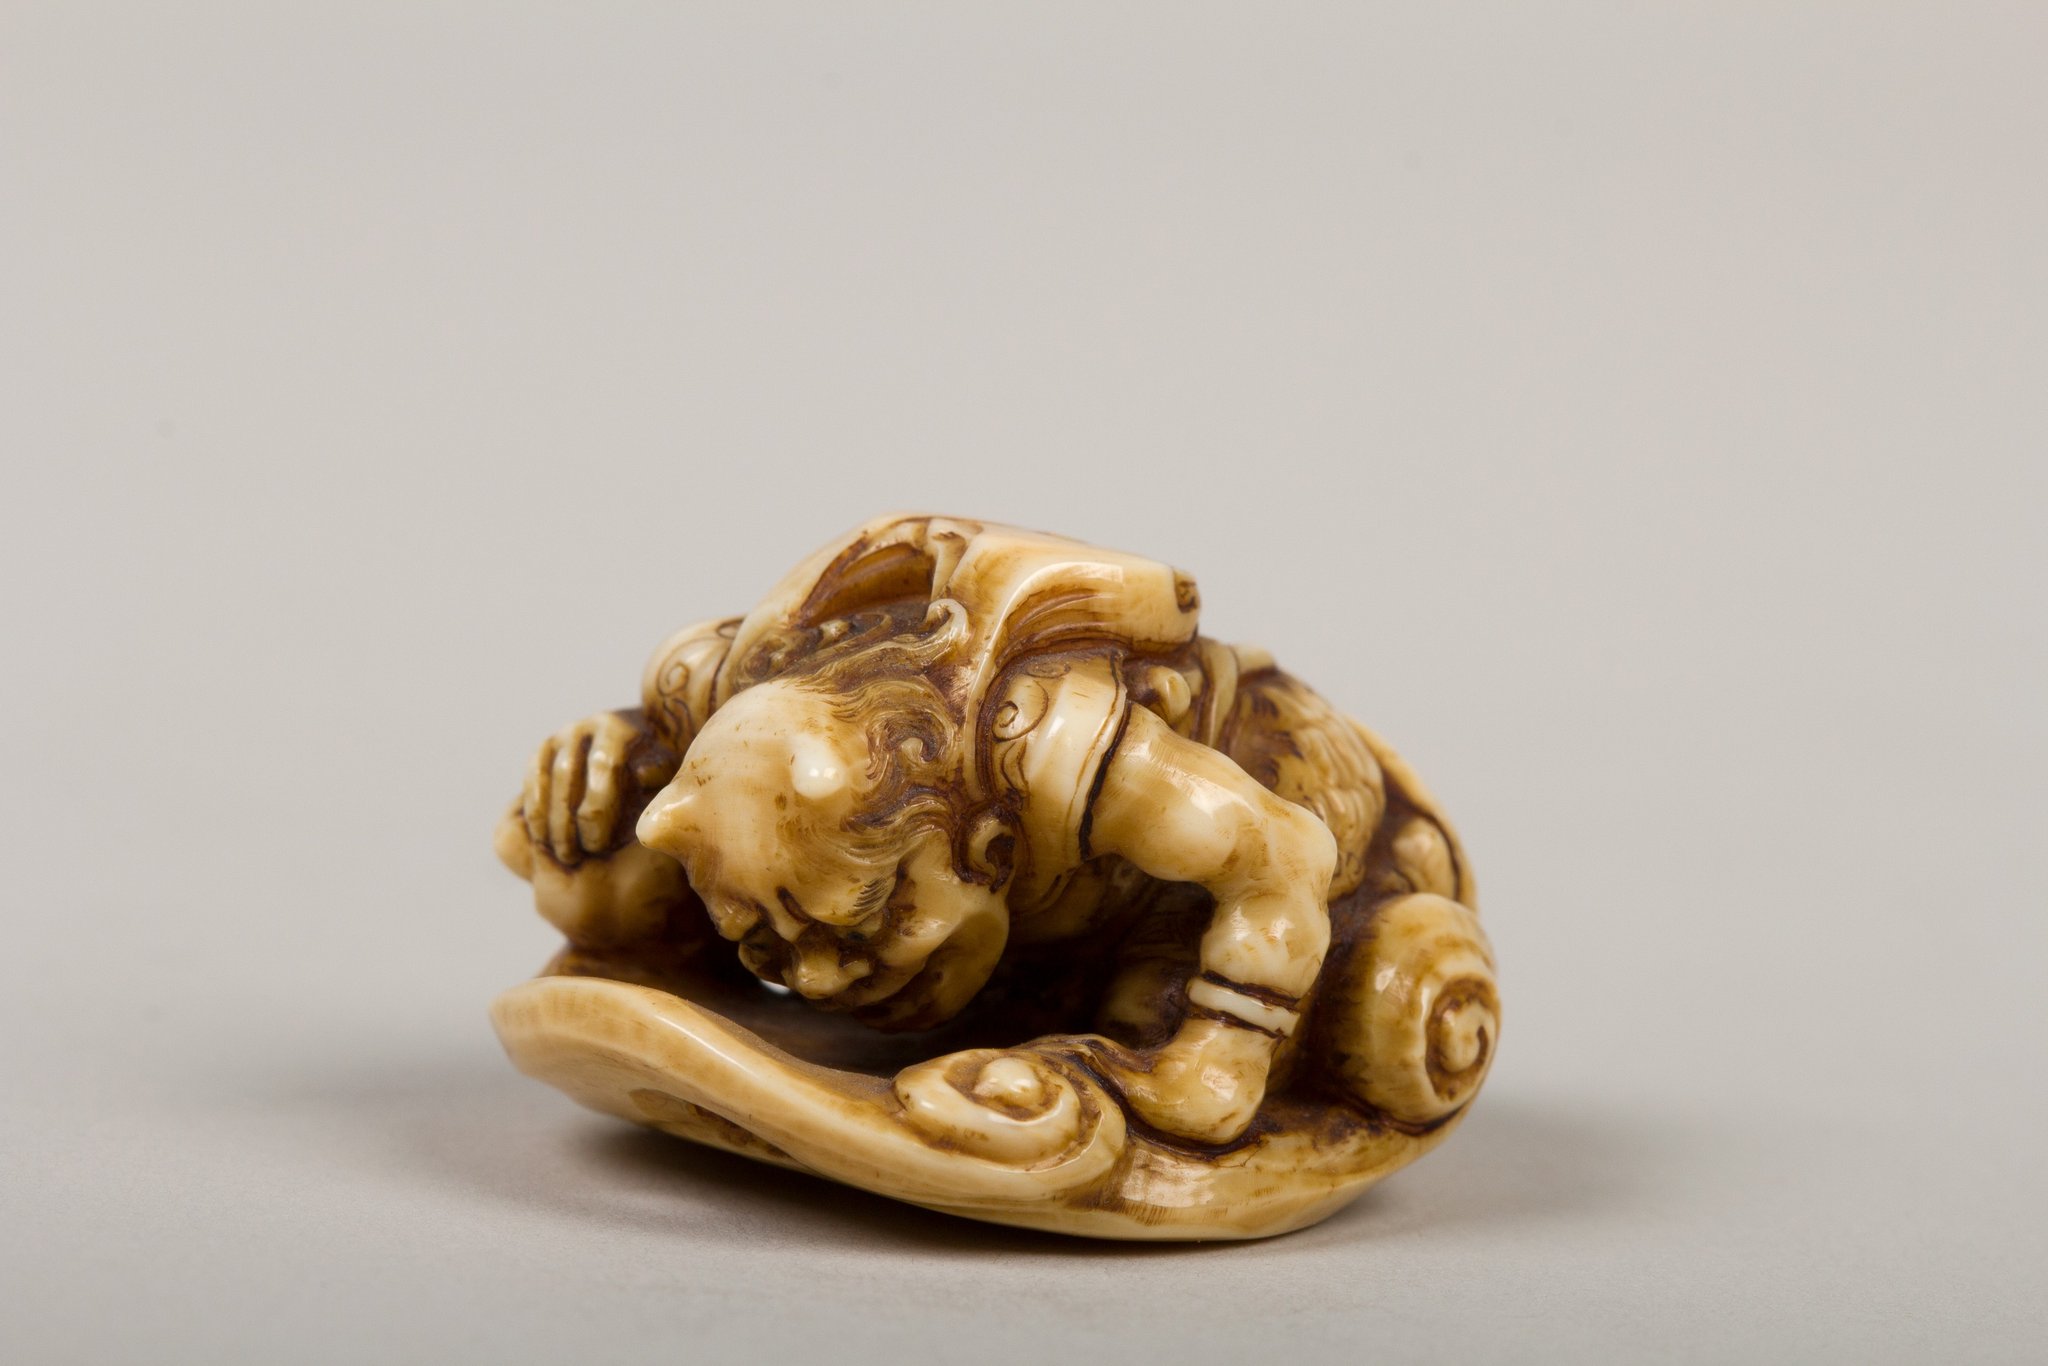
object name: netsuke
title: Netsuke of Demon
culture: japanese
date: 1801-1900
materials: ivory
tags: demons